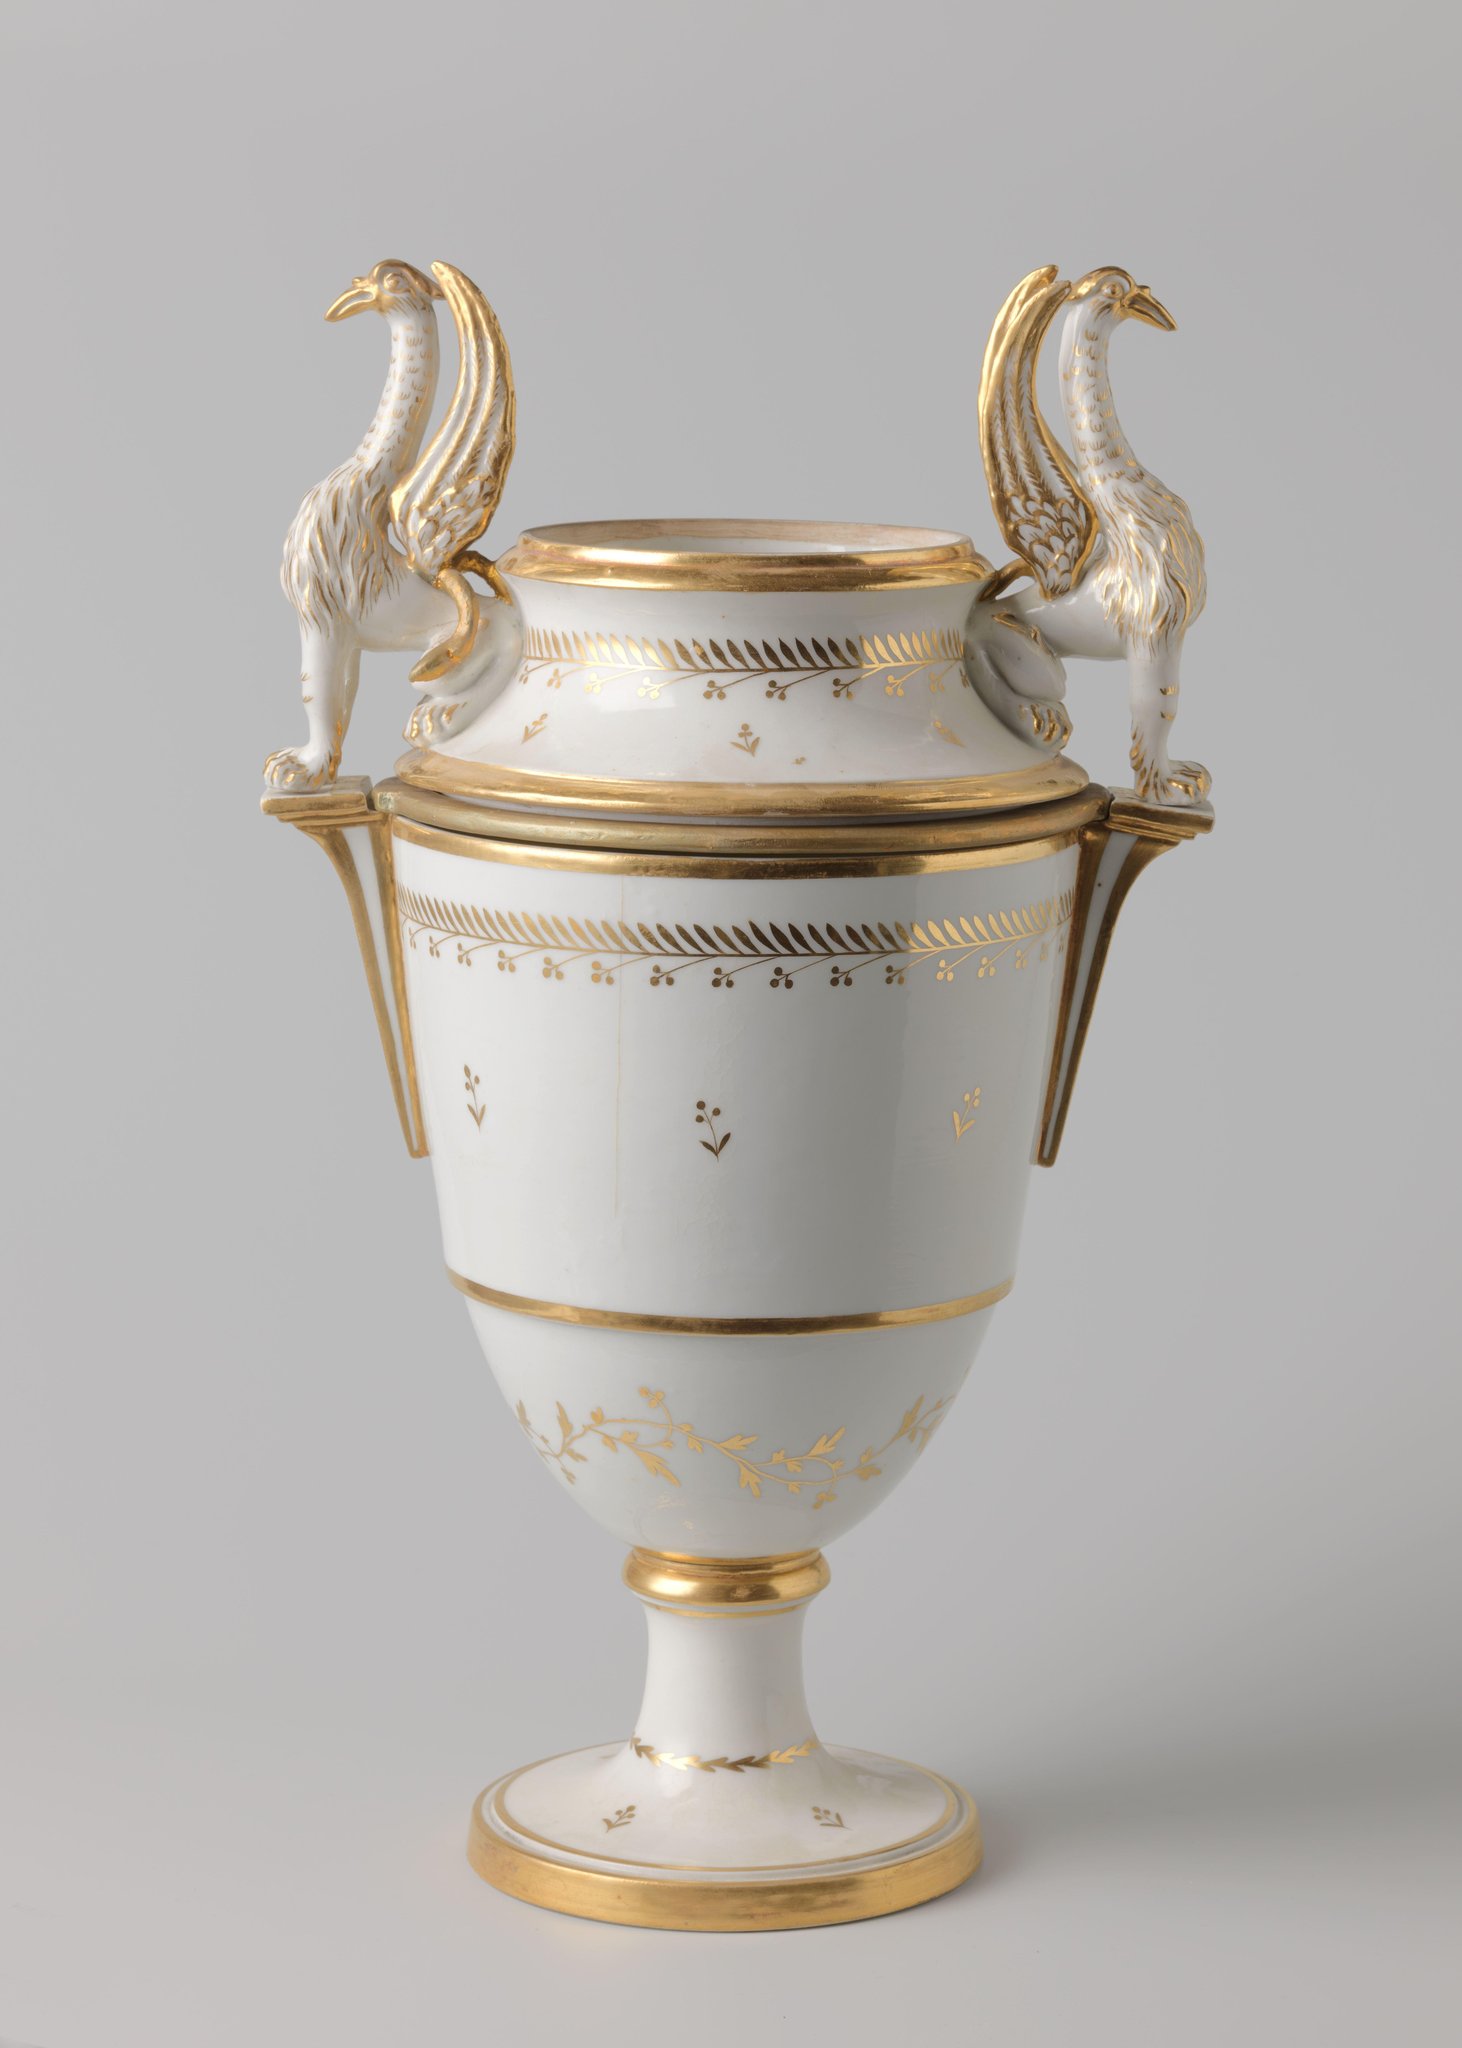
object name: kastanjevaas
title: Punt van deksel van kastanjevaas versierd met griffioenen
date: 1810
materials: porcelain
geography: netherlands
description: Punt van deksel van kastanjevaas waarvan de oren de vorm van griffioenen heeft.